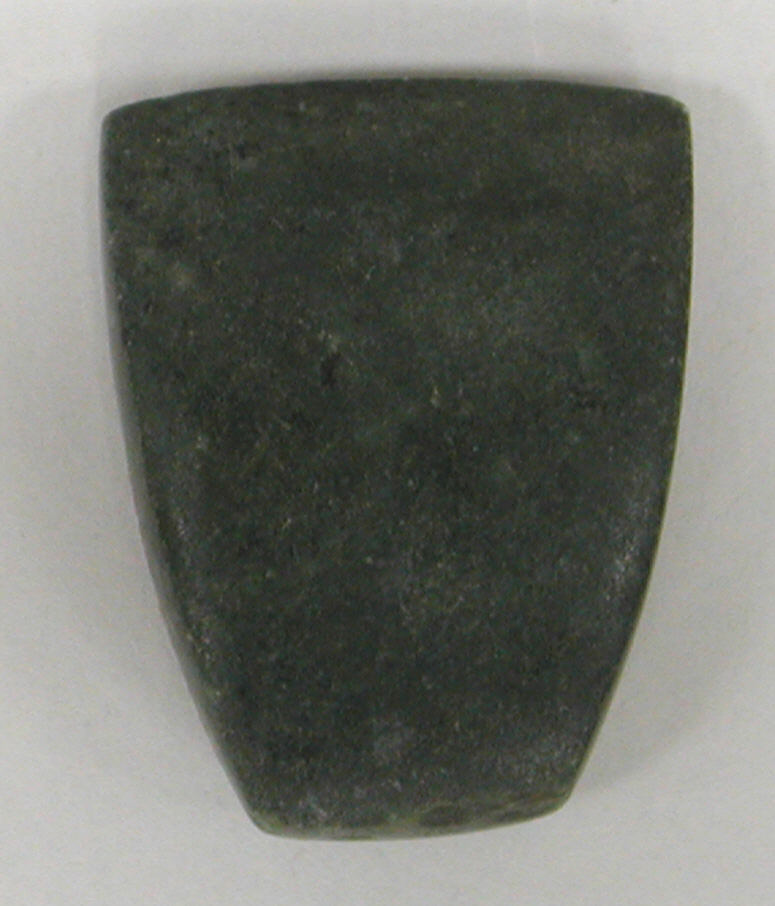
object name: celt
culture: maya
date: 1501-1600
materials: stone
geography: guatemala